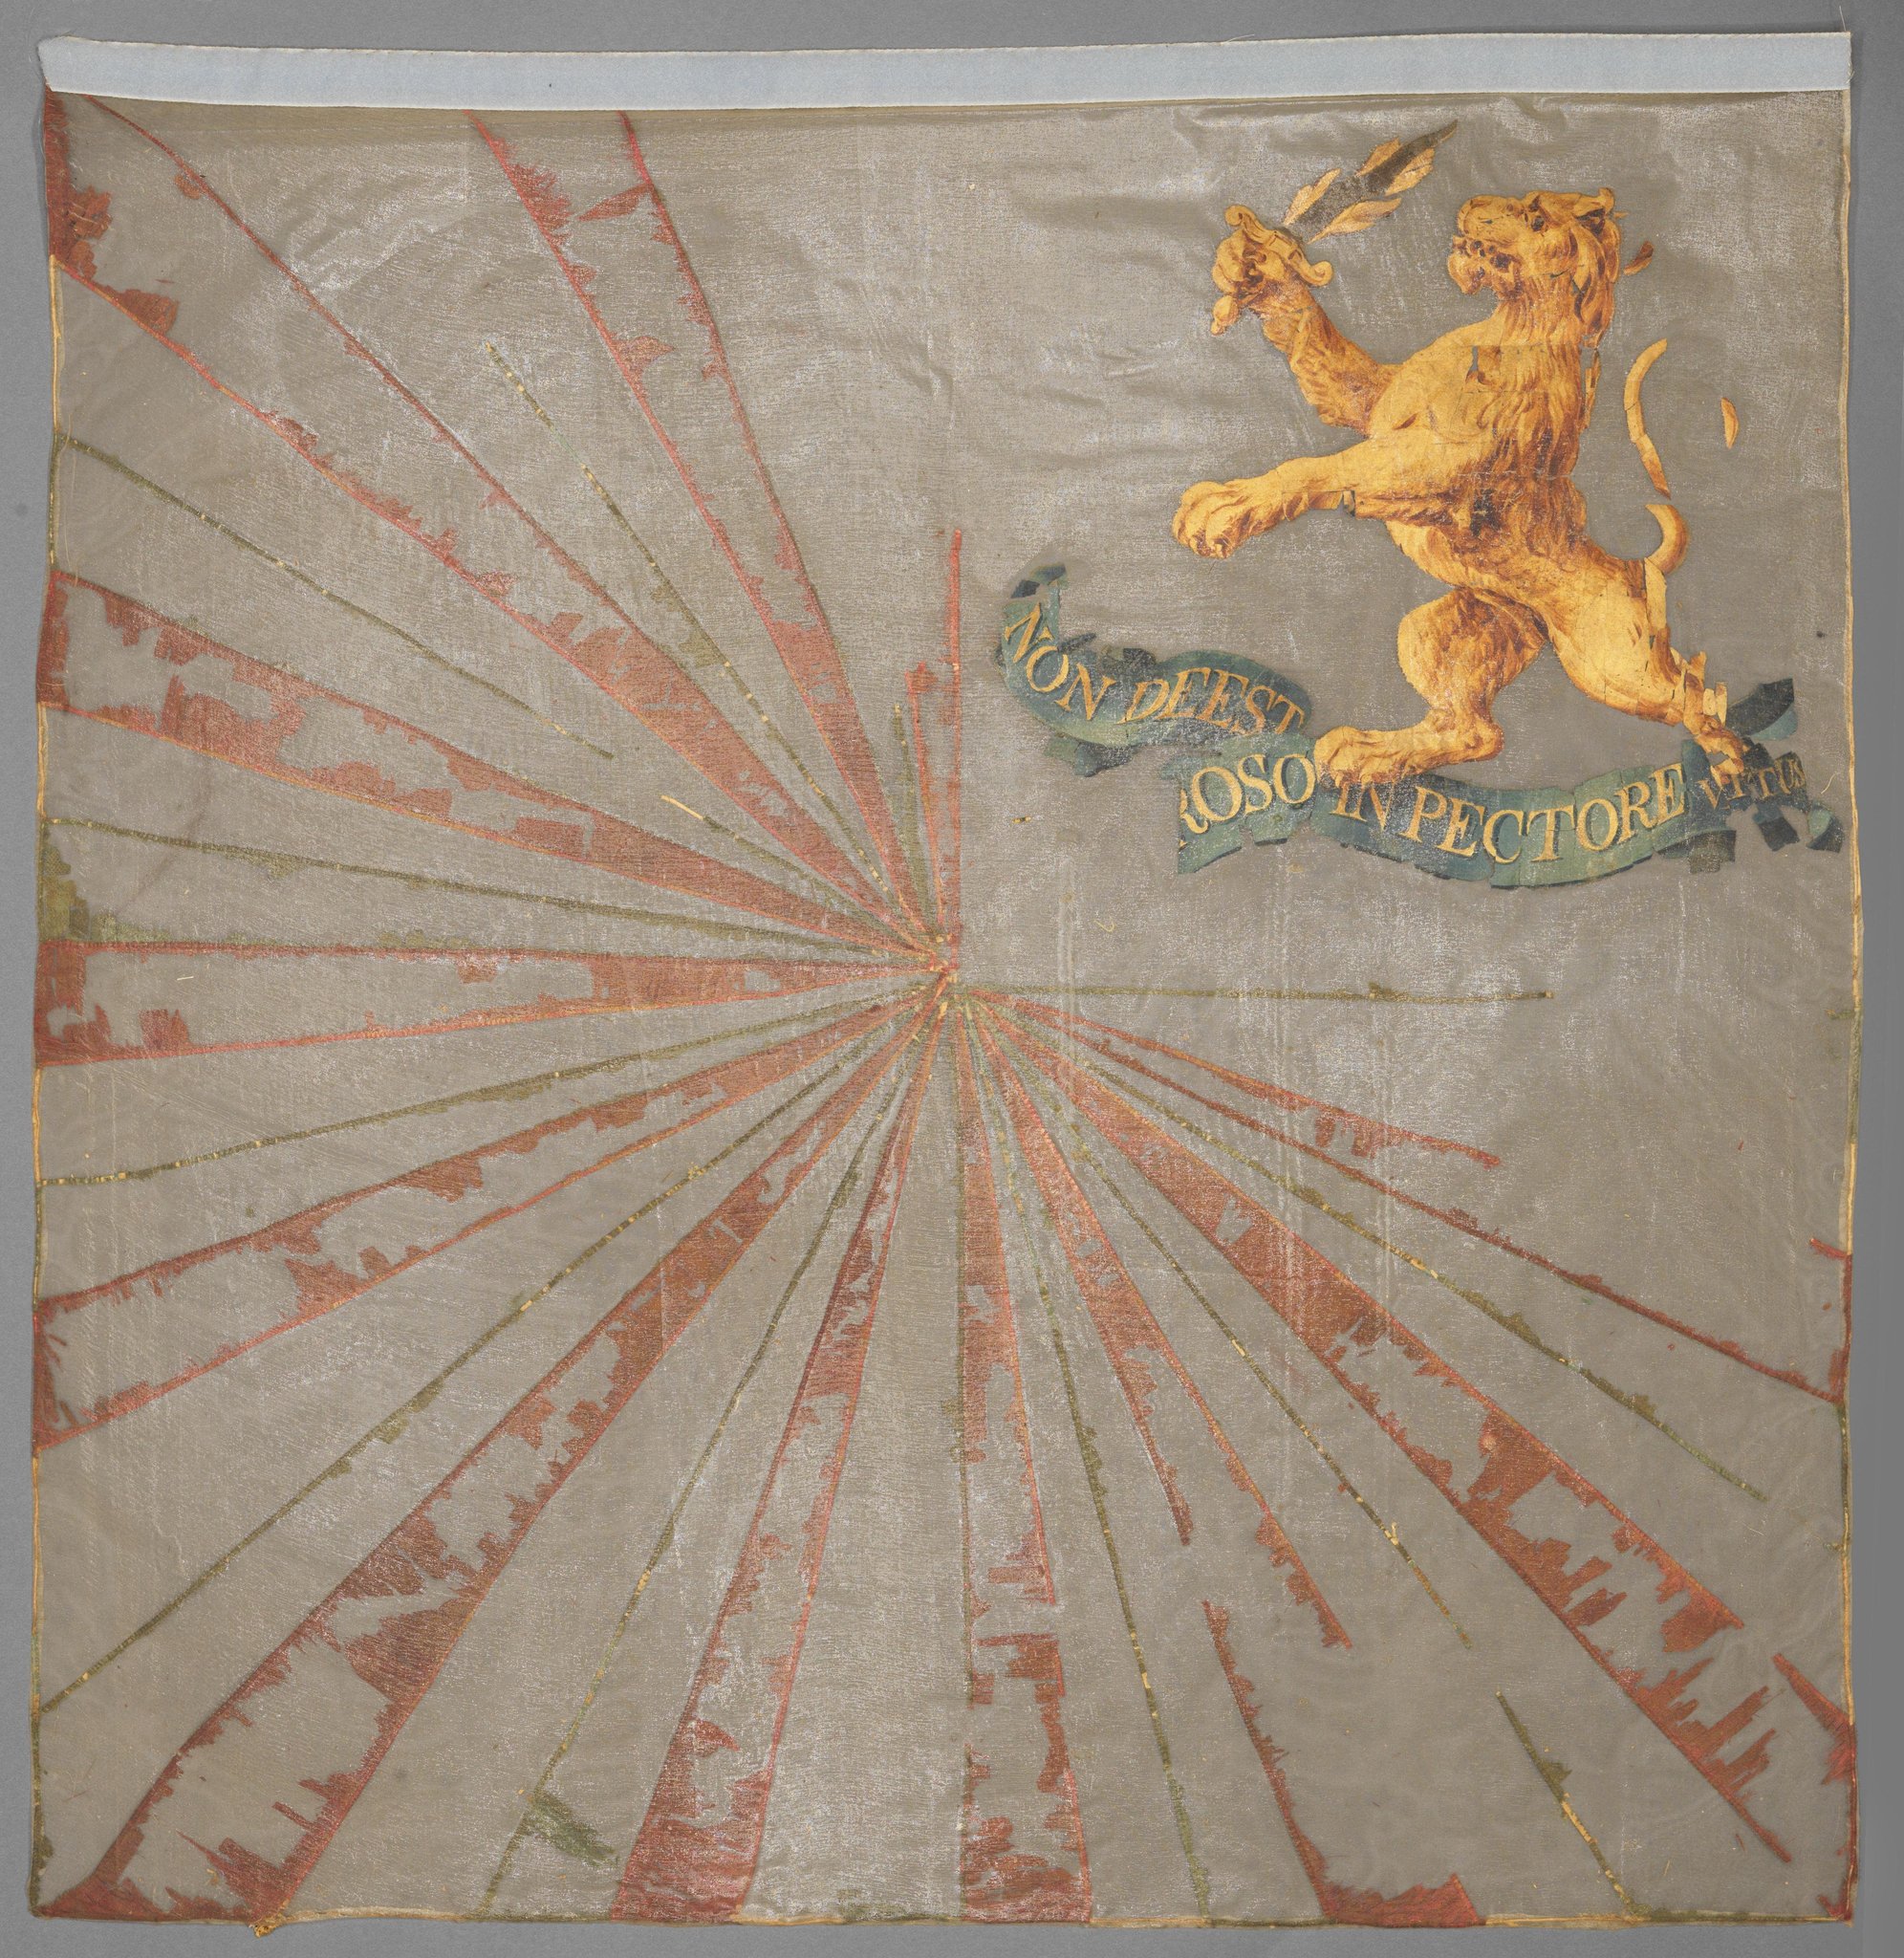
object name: banner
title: Vaandel van een der Zwitserse regimenten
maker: Anonymous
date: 1752-1795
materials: silk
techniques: lining, painted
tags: switzerland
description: Bovenkwartier aan stokzijde beschilderd met gouden klimmende leeuw, met een vlammend zwaard in de rechterklauw, staande op een banderol waarop in gouden klassieke kapitalen: NON DEEST GENEROSO IN PECTORE VIRTUS (het edele gemoed ontbreekt de deugd niet). De overige driekwart van het vaandel bestaat uit genaaide vlamachtige stralen, uit het middelpunt komend: rood, wit en blauw. Paradekant identiek.